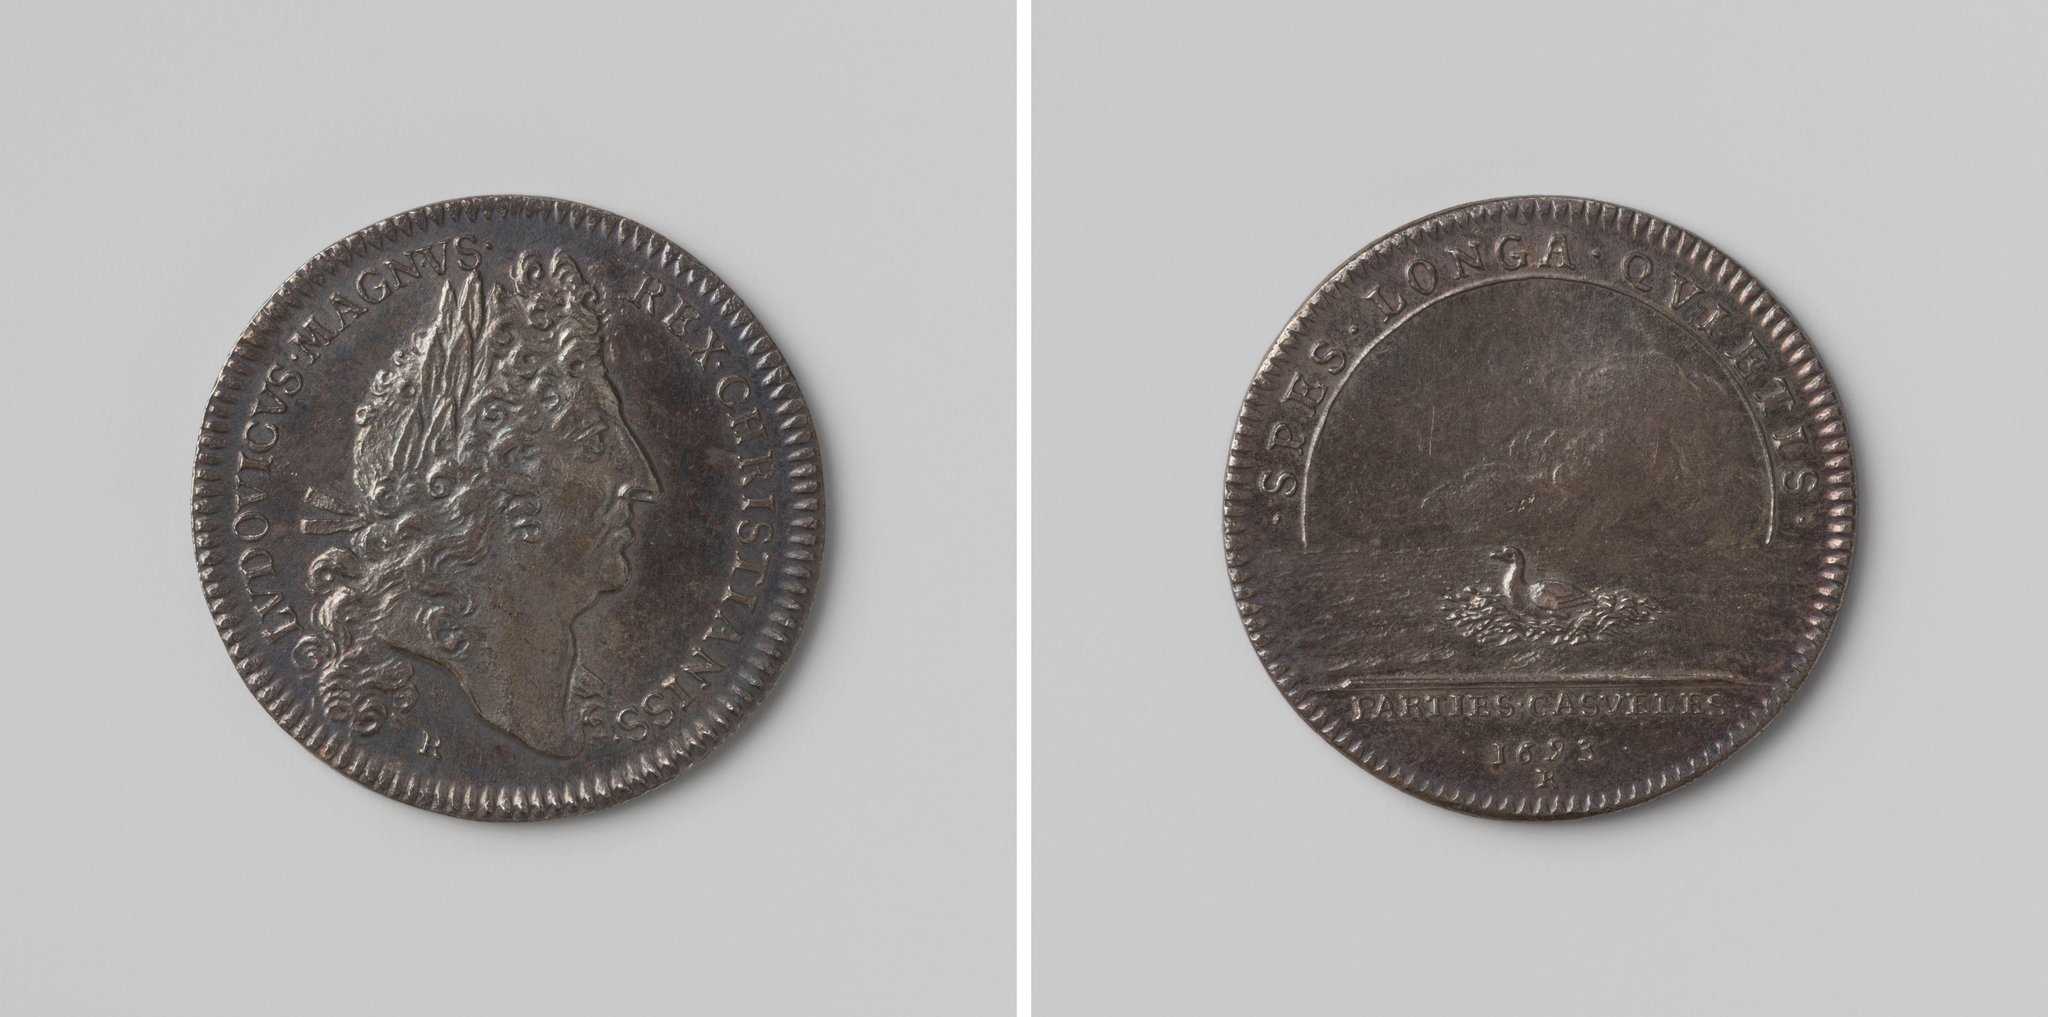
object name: jeton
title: Lodewijk XIV, koning van Frankrijk verlangt naar vrede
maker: joseph roettiers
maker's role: goldsmith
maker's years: 1635-1703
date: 1693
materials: silver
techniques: striking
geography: france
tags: lodewijk xiv (koning van frankrijk)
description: Zilveren penning. Voorzijde: borststuk man met lauwerkrans binnen omschrift. Keerzijde: ijsvogel zittend op nest, drijvend op kalme zee binnen omschrift; afsnede: opschrift